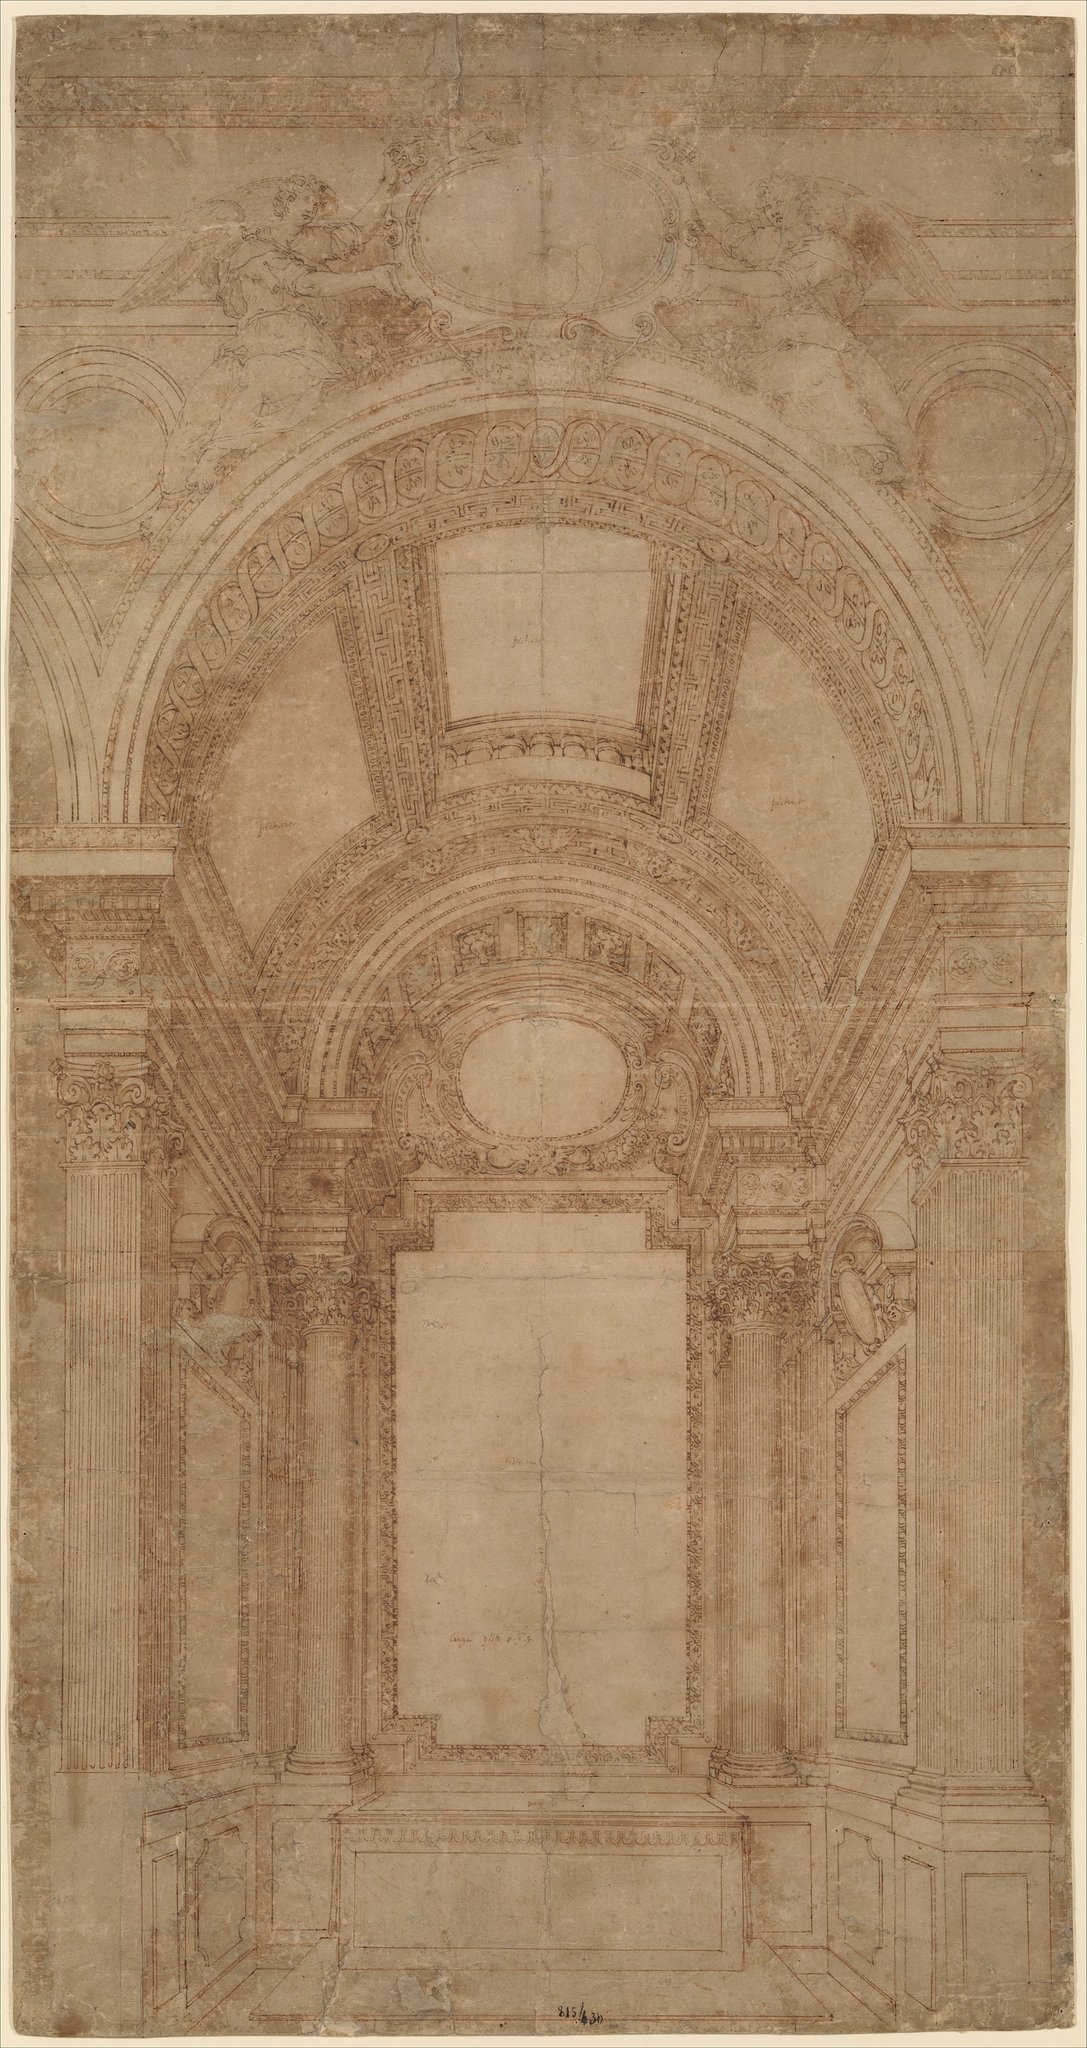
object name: drawing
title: Design for an Elaborate Barrel-Vaulted Chapel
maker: baldassarre tommaso peruzzi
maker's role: artist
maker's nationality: italian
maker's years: 1481-1536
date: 1481-1536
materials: graphite, ink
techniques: pen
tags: architecture,chapels